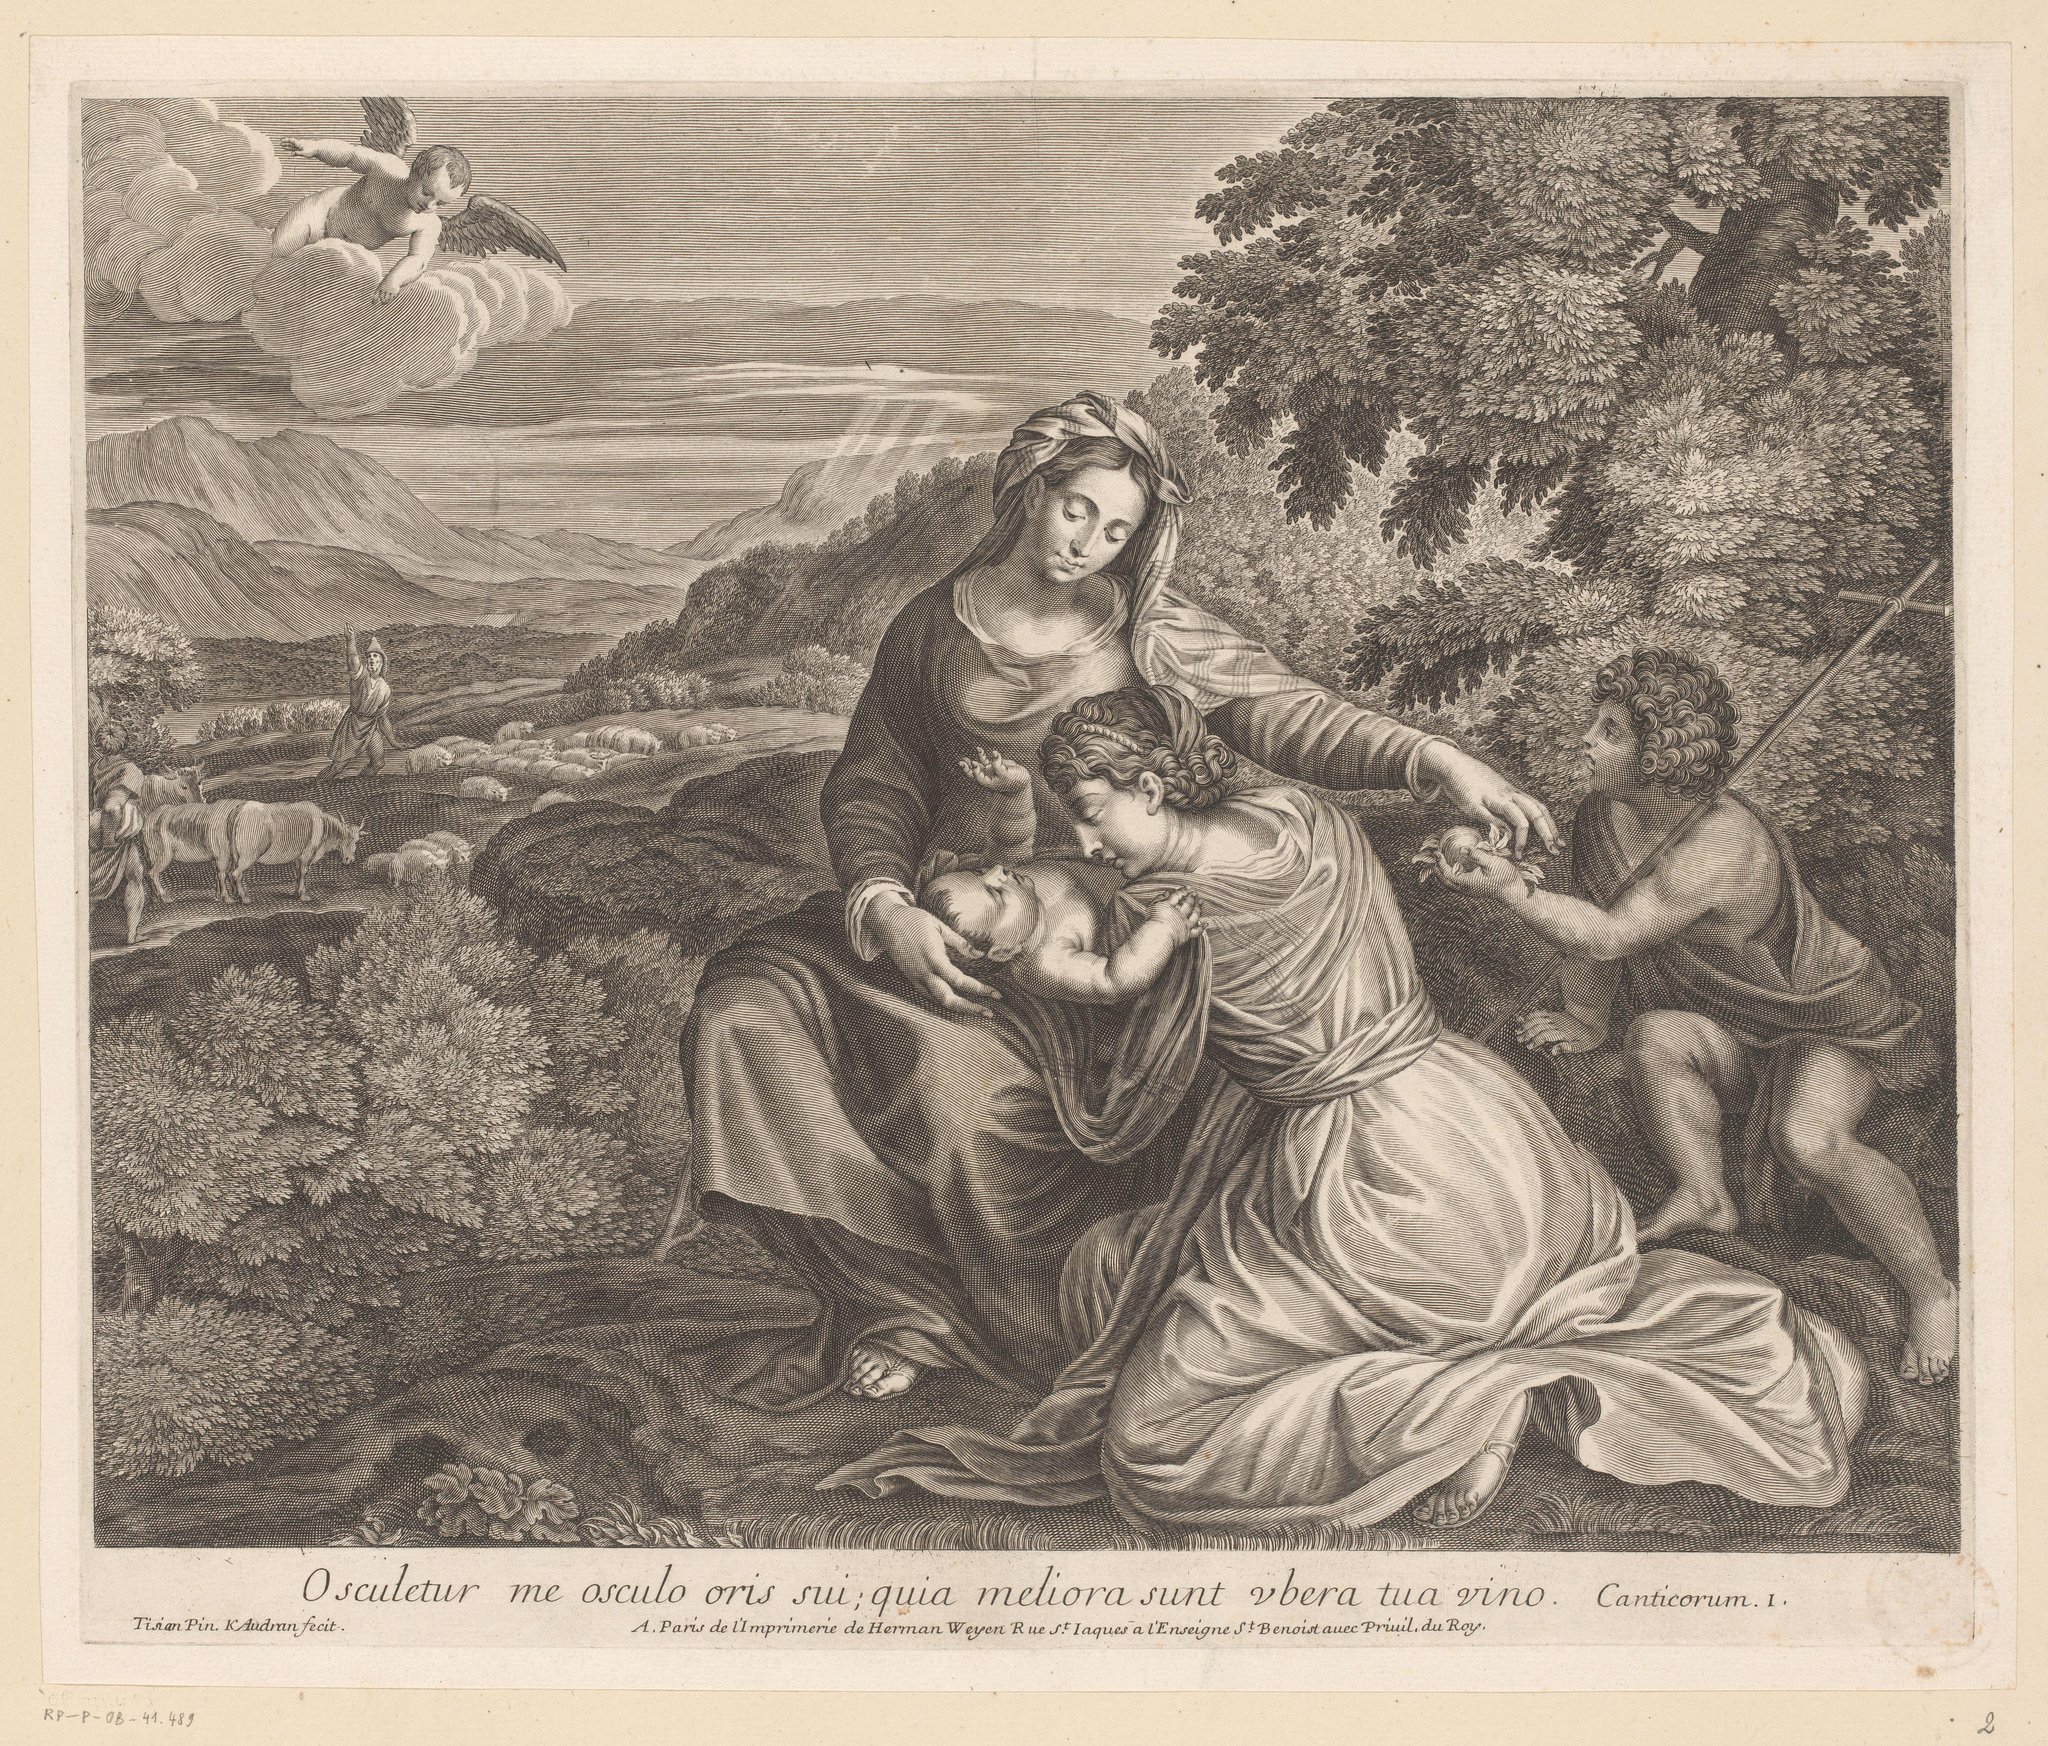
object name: print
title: Osculetur me osculo oris sui (...)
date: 1604-1672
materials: paper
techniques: engraving, etching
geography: paris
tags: personal devotion of st. catherine, annunciation of christ's birth to the shepherds (and/or shepherdesses) at night; a host of singing angels in the air, the christ-child and john the baptist (as child) with others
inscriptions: collector's mark: Lugt 240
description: Maria met het Kind op de schoot in aanwezigheid van H. Catharina en Johannes de Doper met voorstelling van de verkondiging aan de herders op de achtergrond.